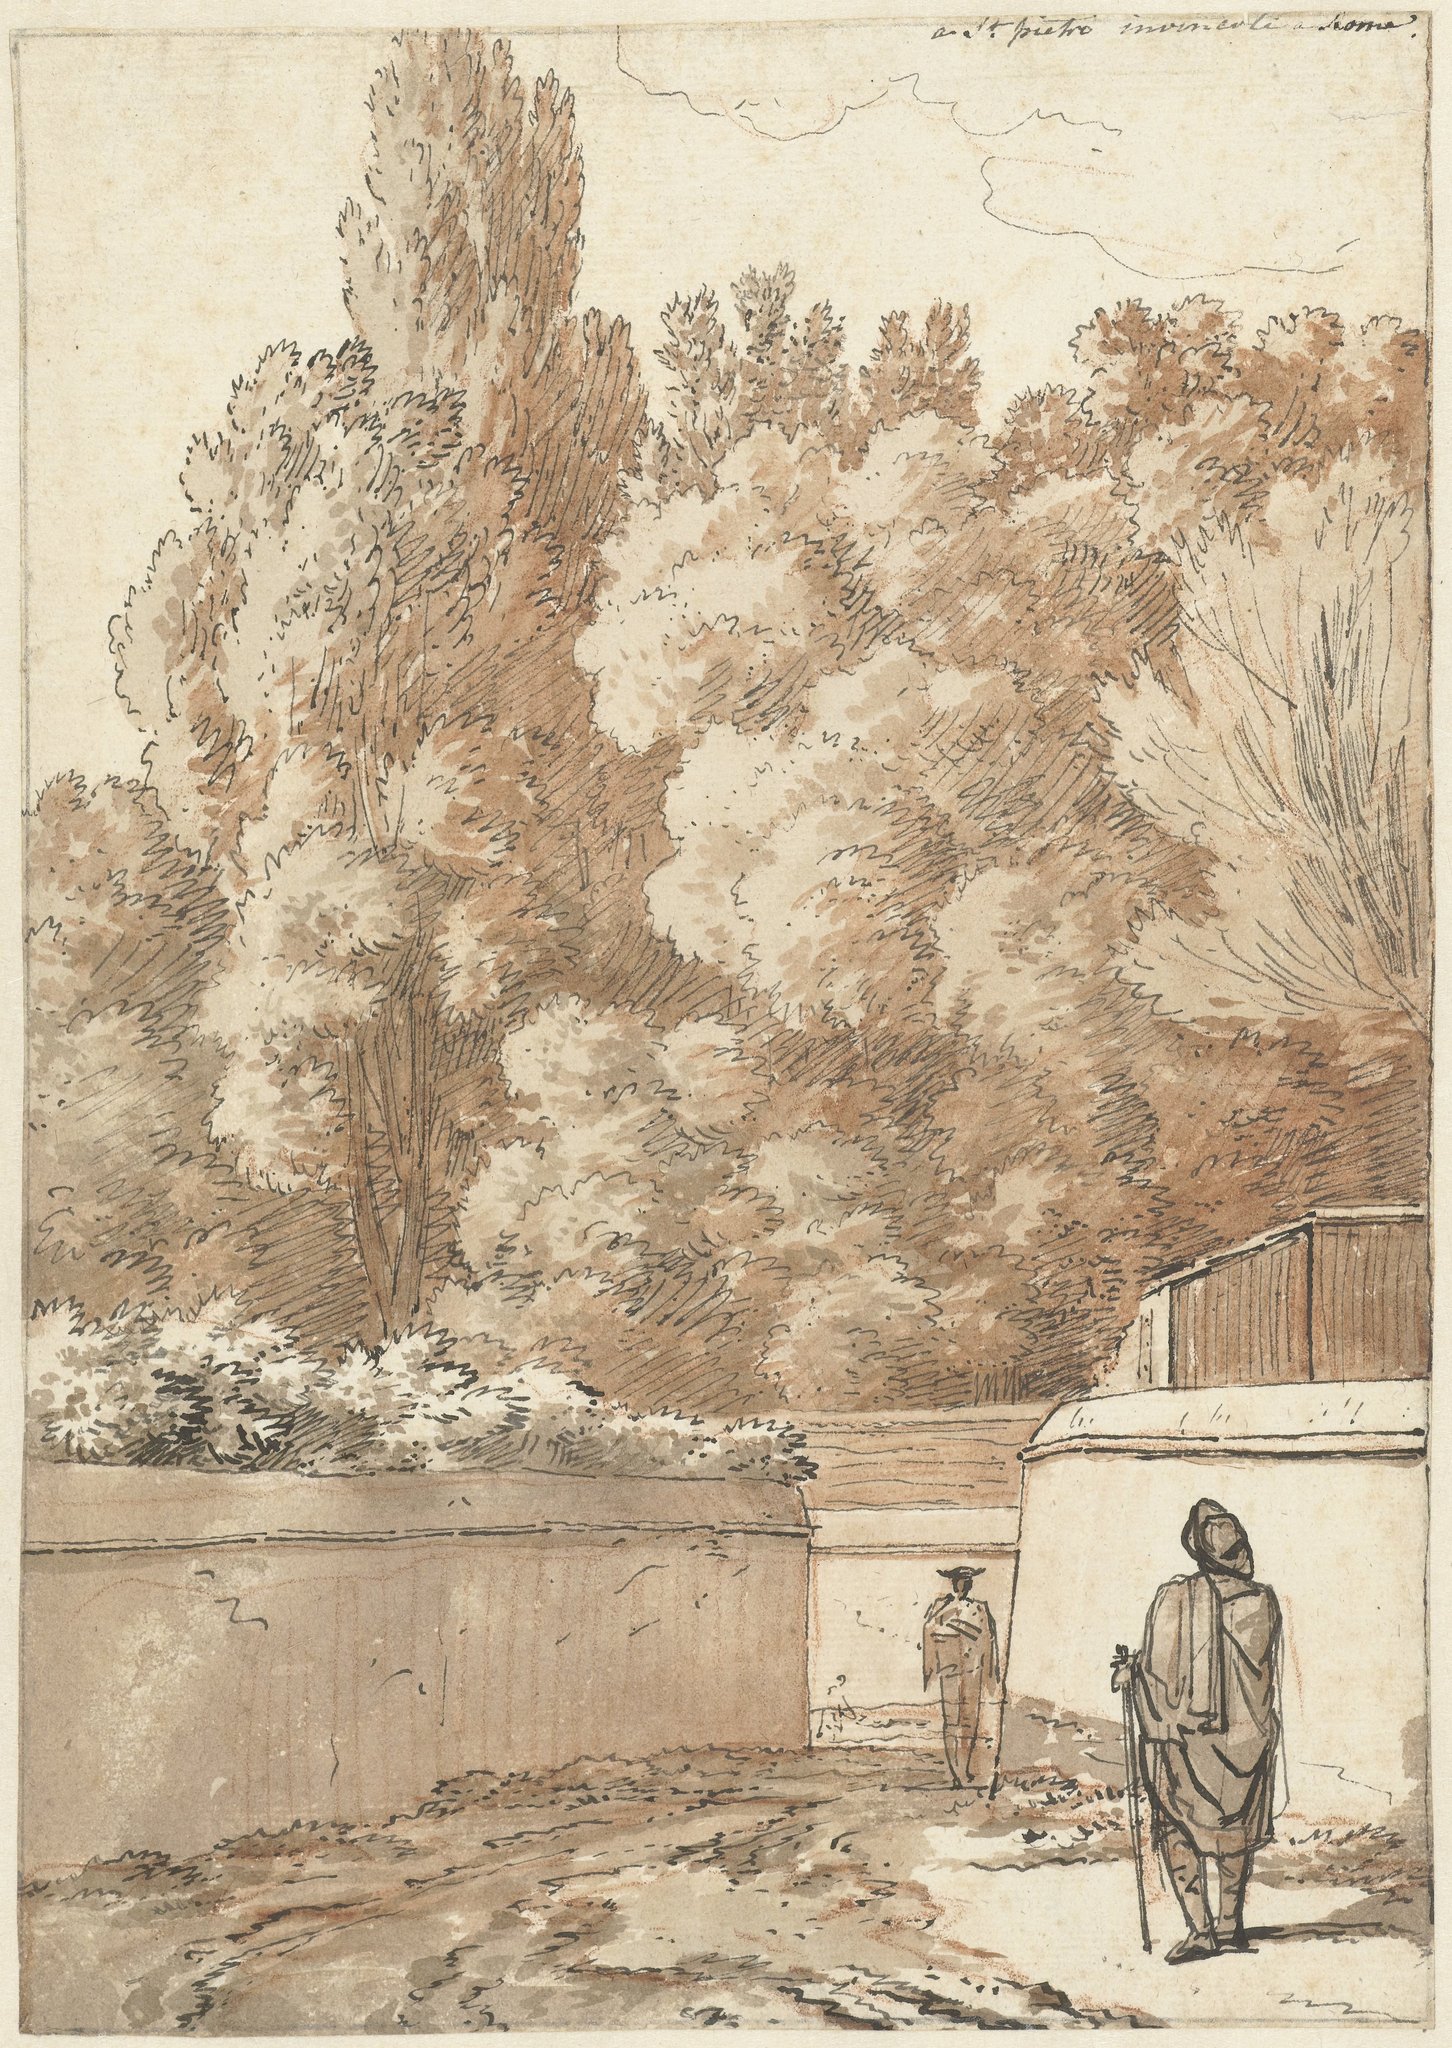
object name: drawing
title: Wandelaars tussen tuinmuren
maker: jean grandjean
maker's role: draughtsman, print maker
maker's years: 1752-1781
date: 1765-1781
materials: chalk, ink, paper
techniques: brush, pen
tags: garden, rome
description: Wandelaars tussen tuinmuren; op de achtergrond bomen van een park bij San Pietro in Vincoli te Rome.